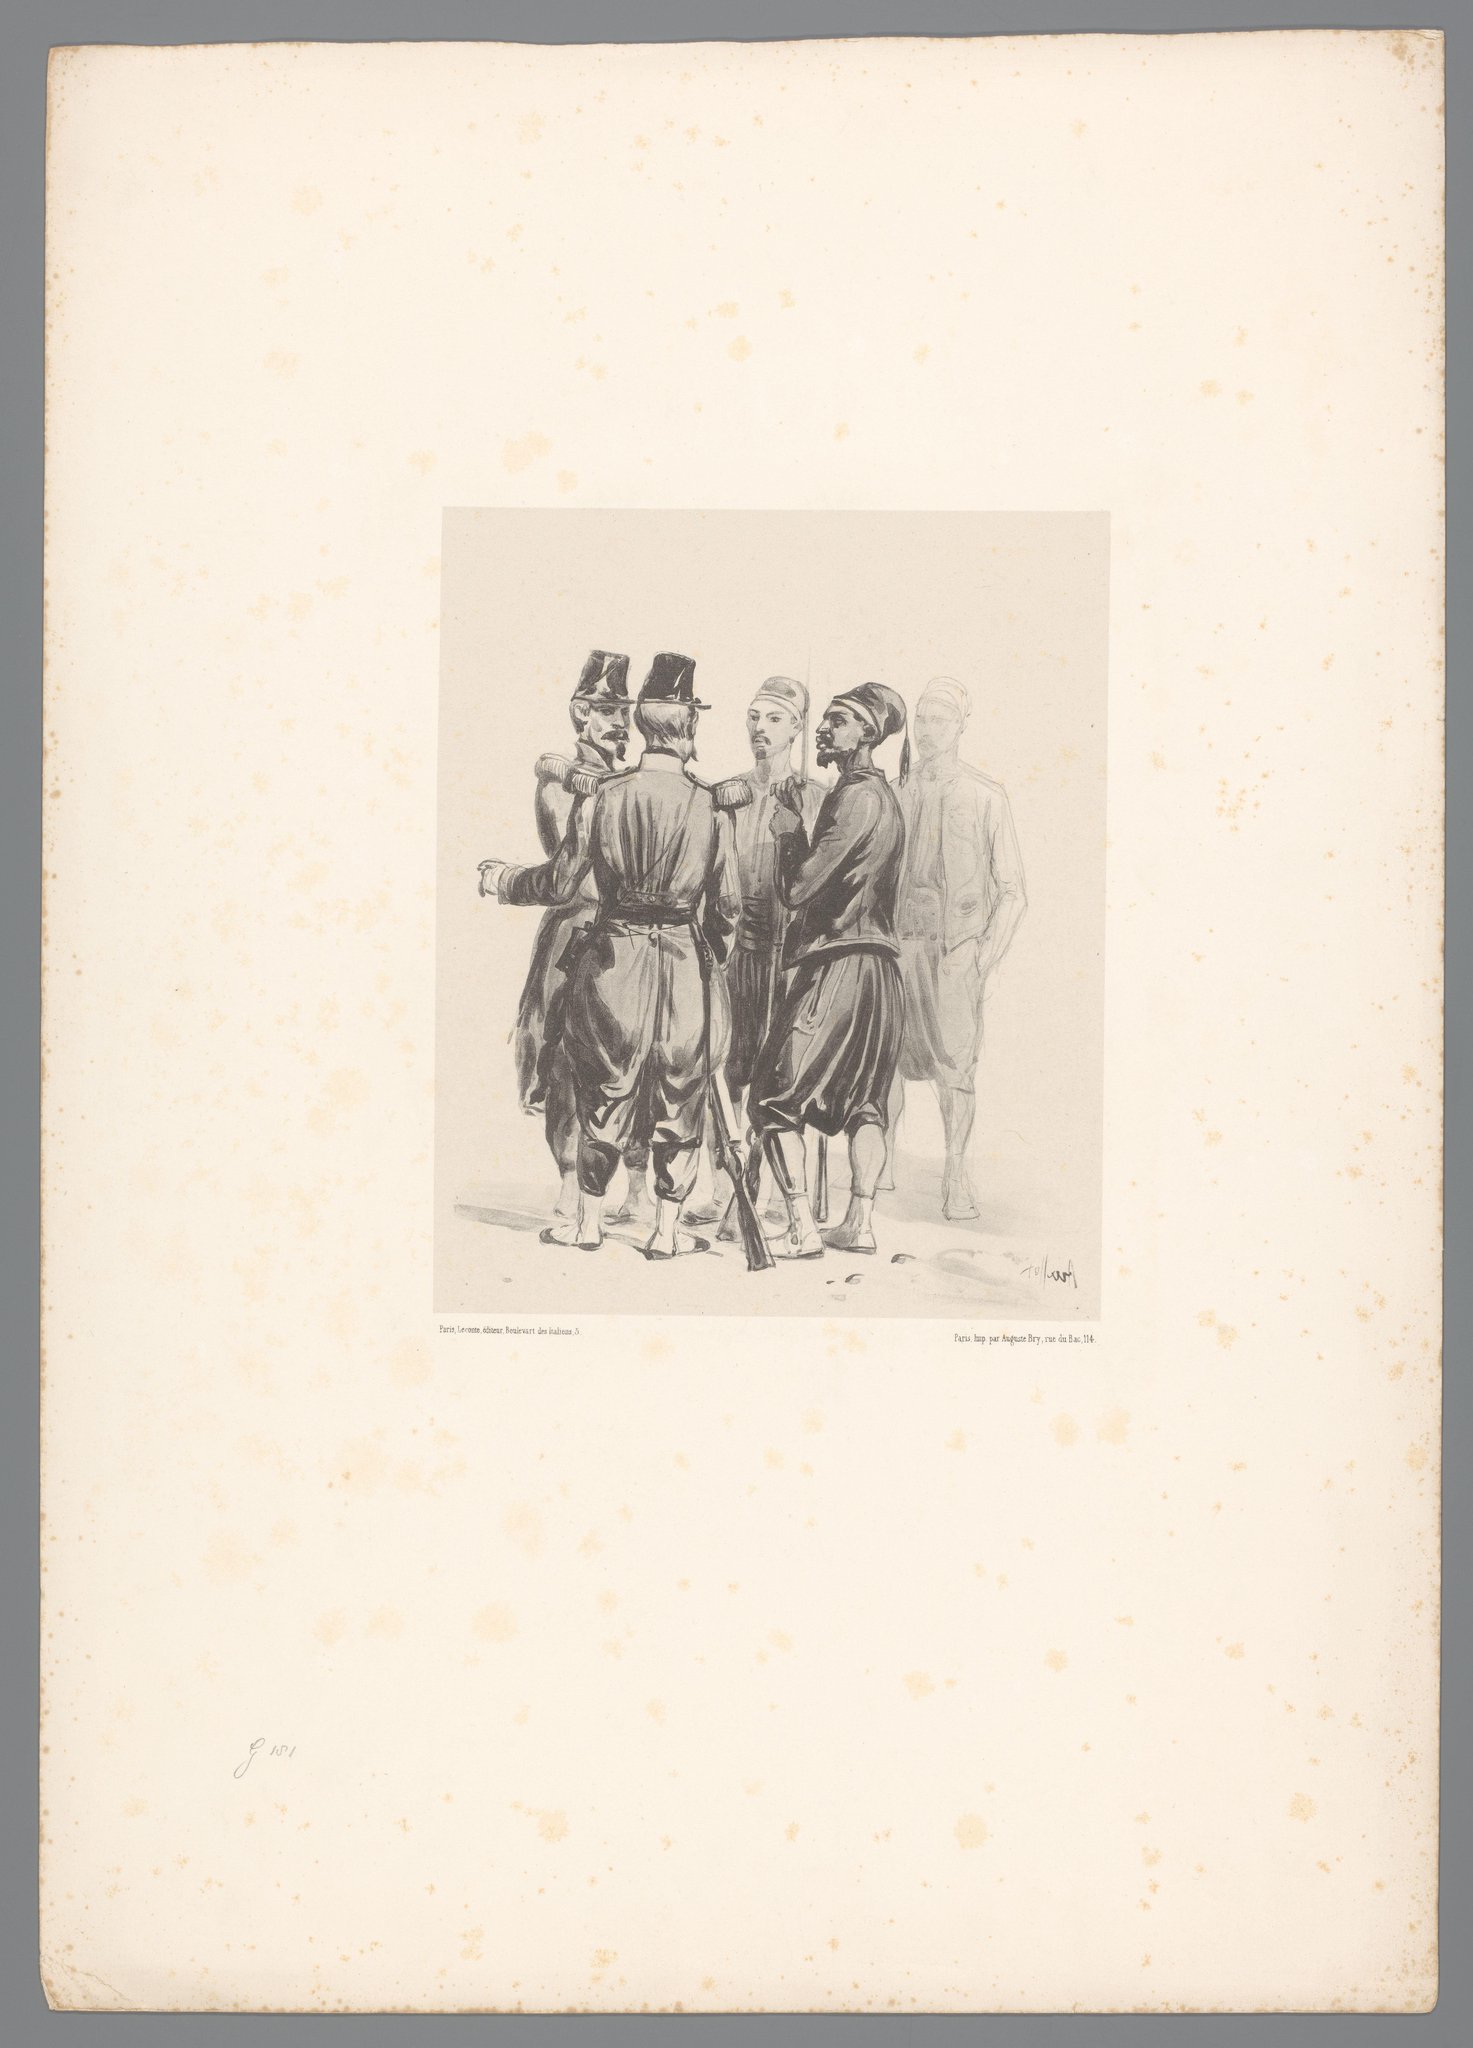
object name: print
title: Twee infantristen en drie Turkse mannen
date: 1844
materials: paper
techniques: lithograph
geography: paris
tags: private soldier (+ infantry), adult man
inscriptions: collector's mark: Lugt 964